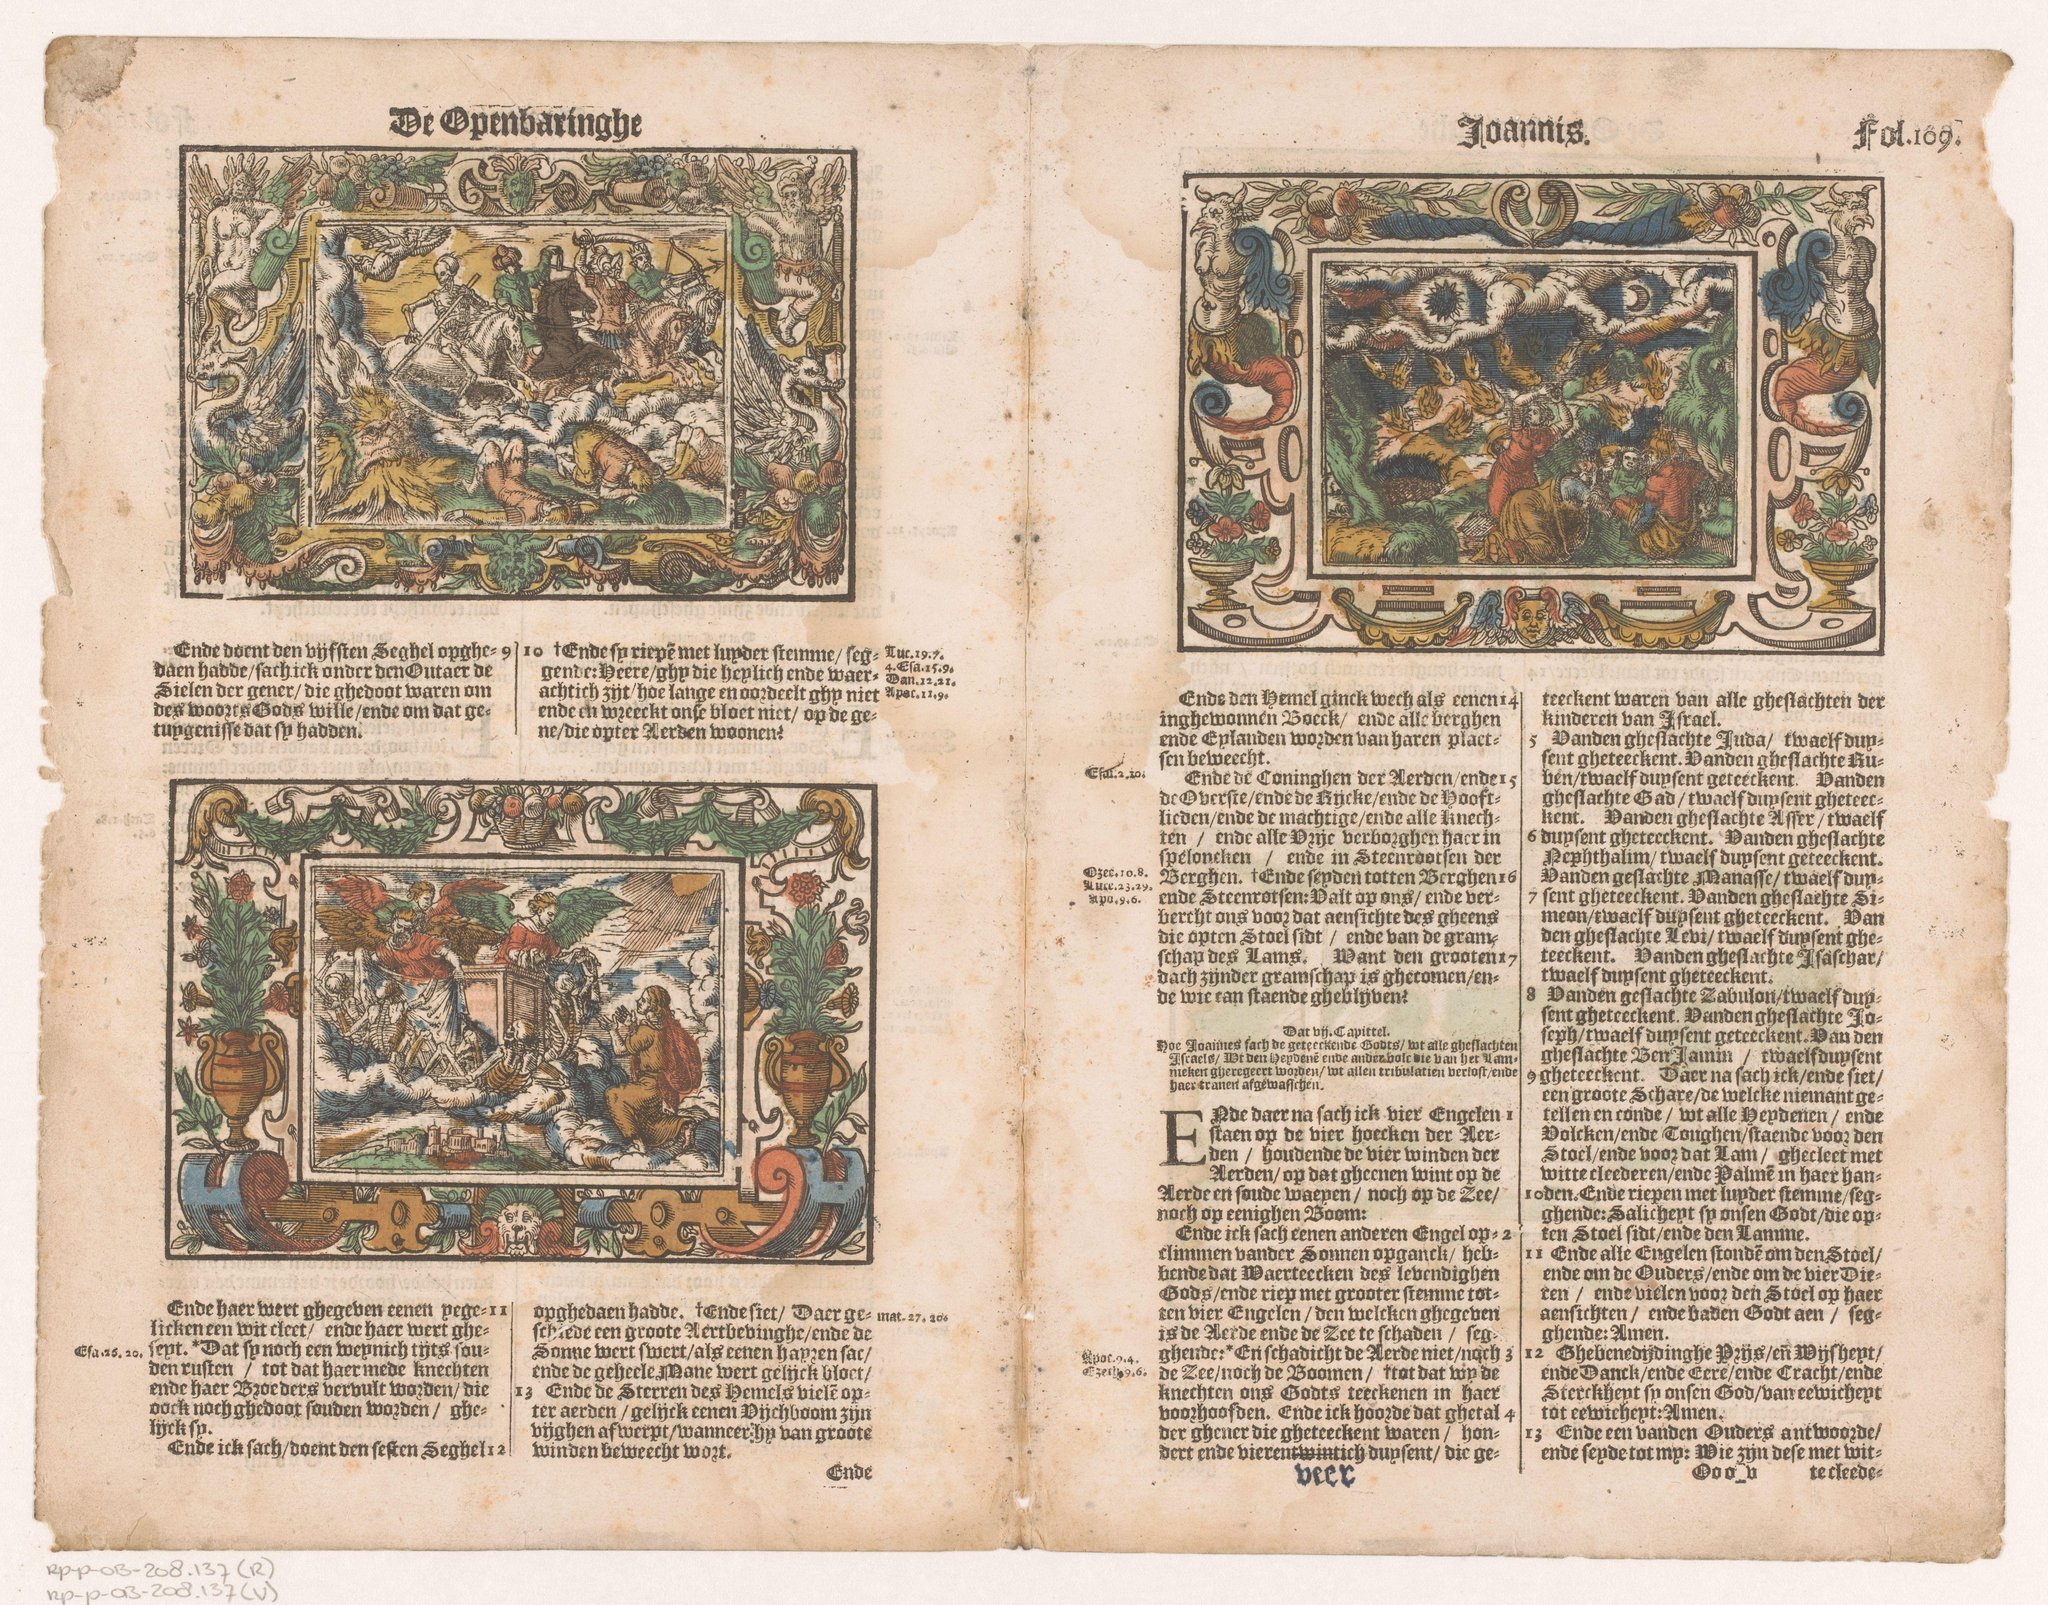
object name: book illustration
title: Drie voorstellingen uit de Openbaring van Johannes (Apocalyps)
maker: Anonymous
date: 1600-1699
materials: paper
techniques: hand coloring, letterpress printing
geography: netherlands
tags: the revelation of john, the apocalypse, the four horsemen of the apocalypse, opening of the sixth seal: a great earthquake, the sun turns black, the moon red as blood, and the stars fall on earth; mankind hiding in caves, opening of the fifth seal: white robes are given to (the souls of) the martyrs under the altar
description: De vier apocalyptische ruiters, het verbreken van het vijfde zegel en het verbreken van het zesde zegel.